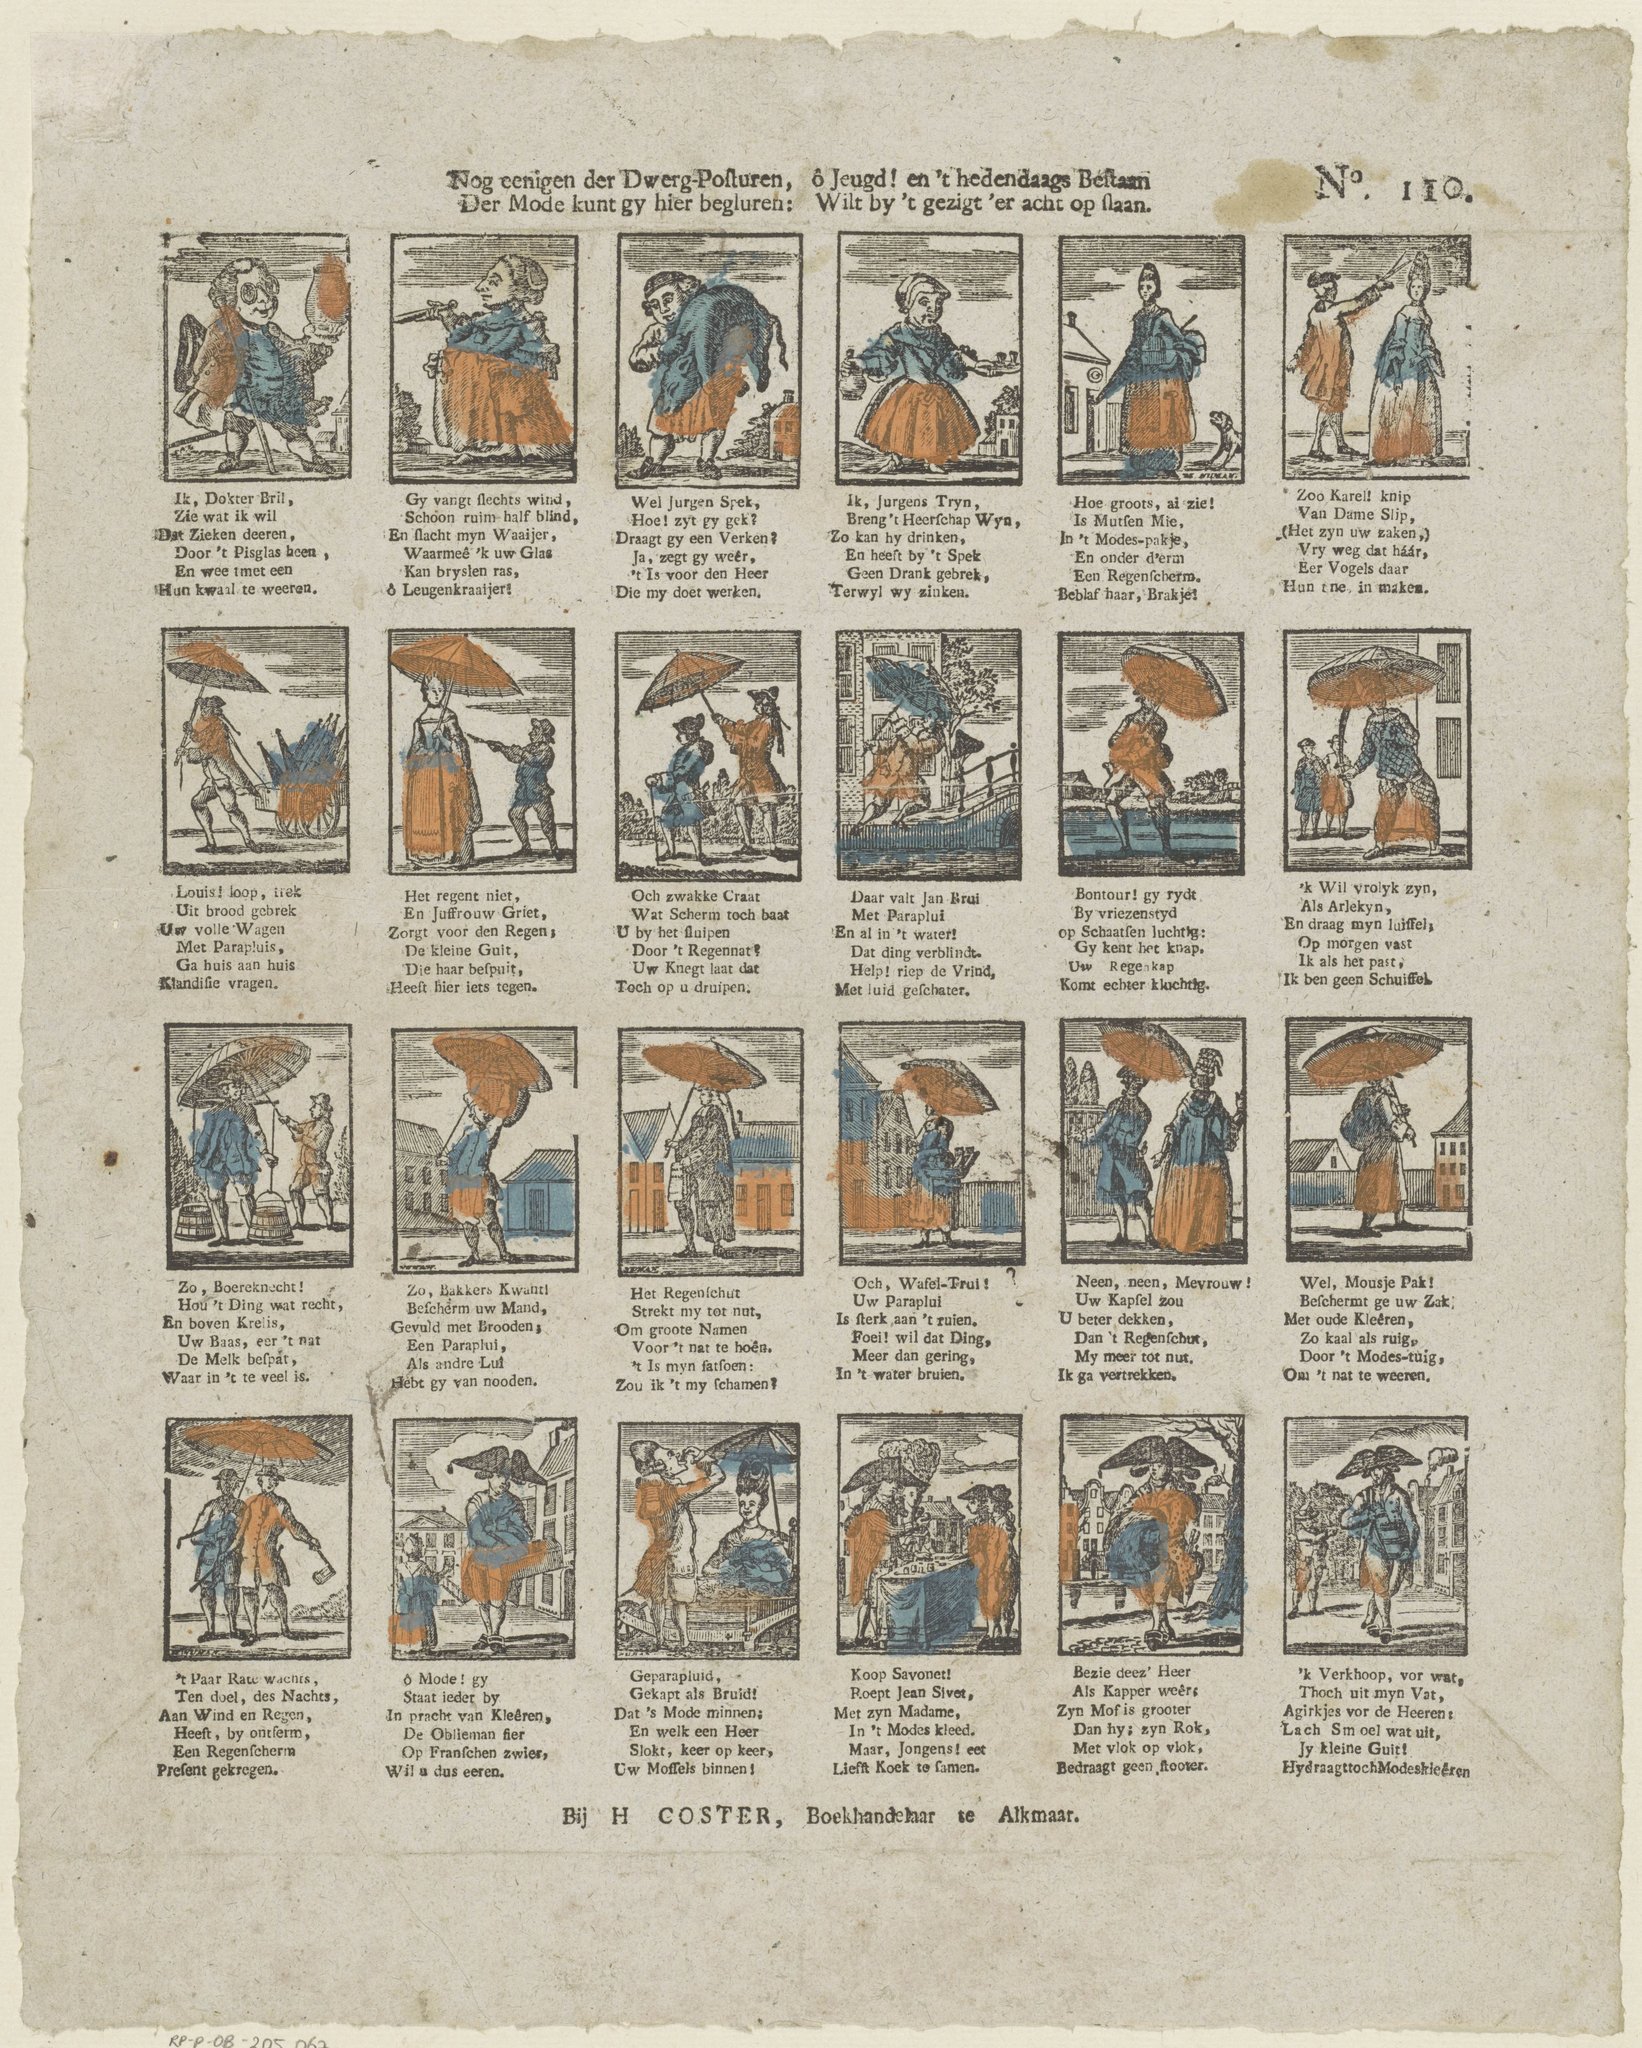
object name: print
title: Nog eenigen der dwerg-posturen, ô jeugd! en 't hedendaags bestaan / Der mode kunt gy hier begluren: Wilt by 't gezigt 'er acht op slaan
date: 1806-1830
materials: paper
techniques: colour, letterpress printing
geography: netherlands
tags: fashion, clothing, caricatures (human types), fashion, comedy, parasol, sunshade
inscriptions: collector's mark: Lugt 2760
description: Spotprent op de mode met 24 voorstellingen van een mannen, vrouwen en karikaturele figuren met parasollen. Onder elke afbeelding een zesregelig vers. Genummerd rechtsboven: No. 110.